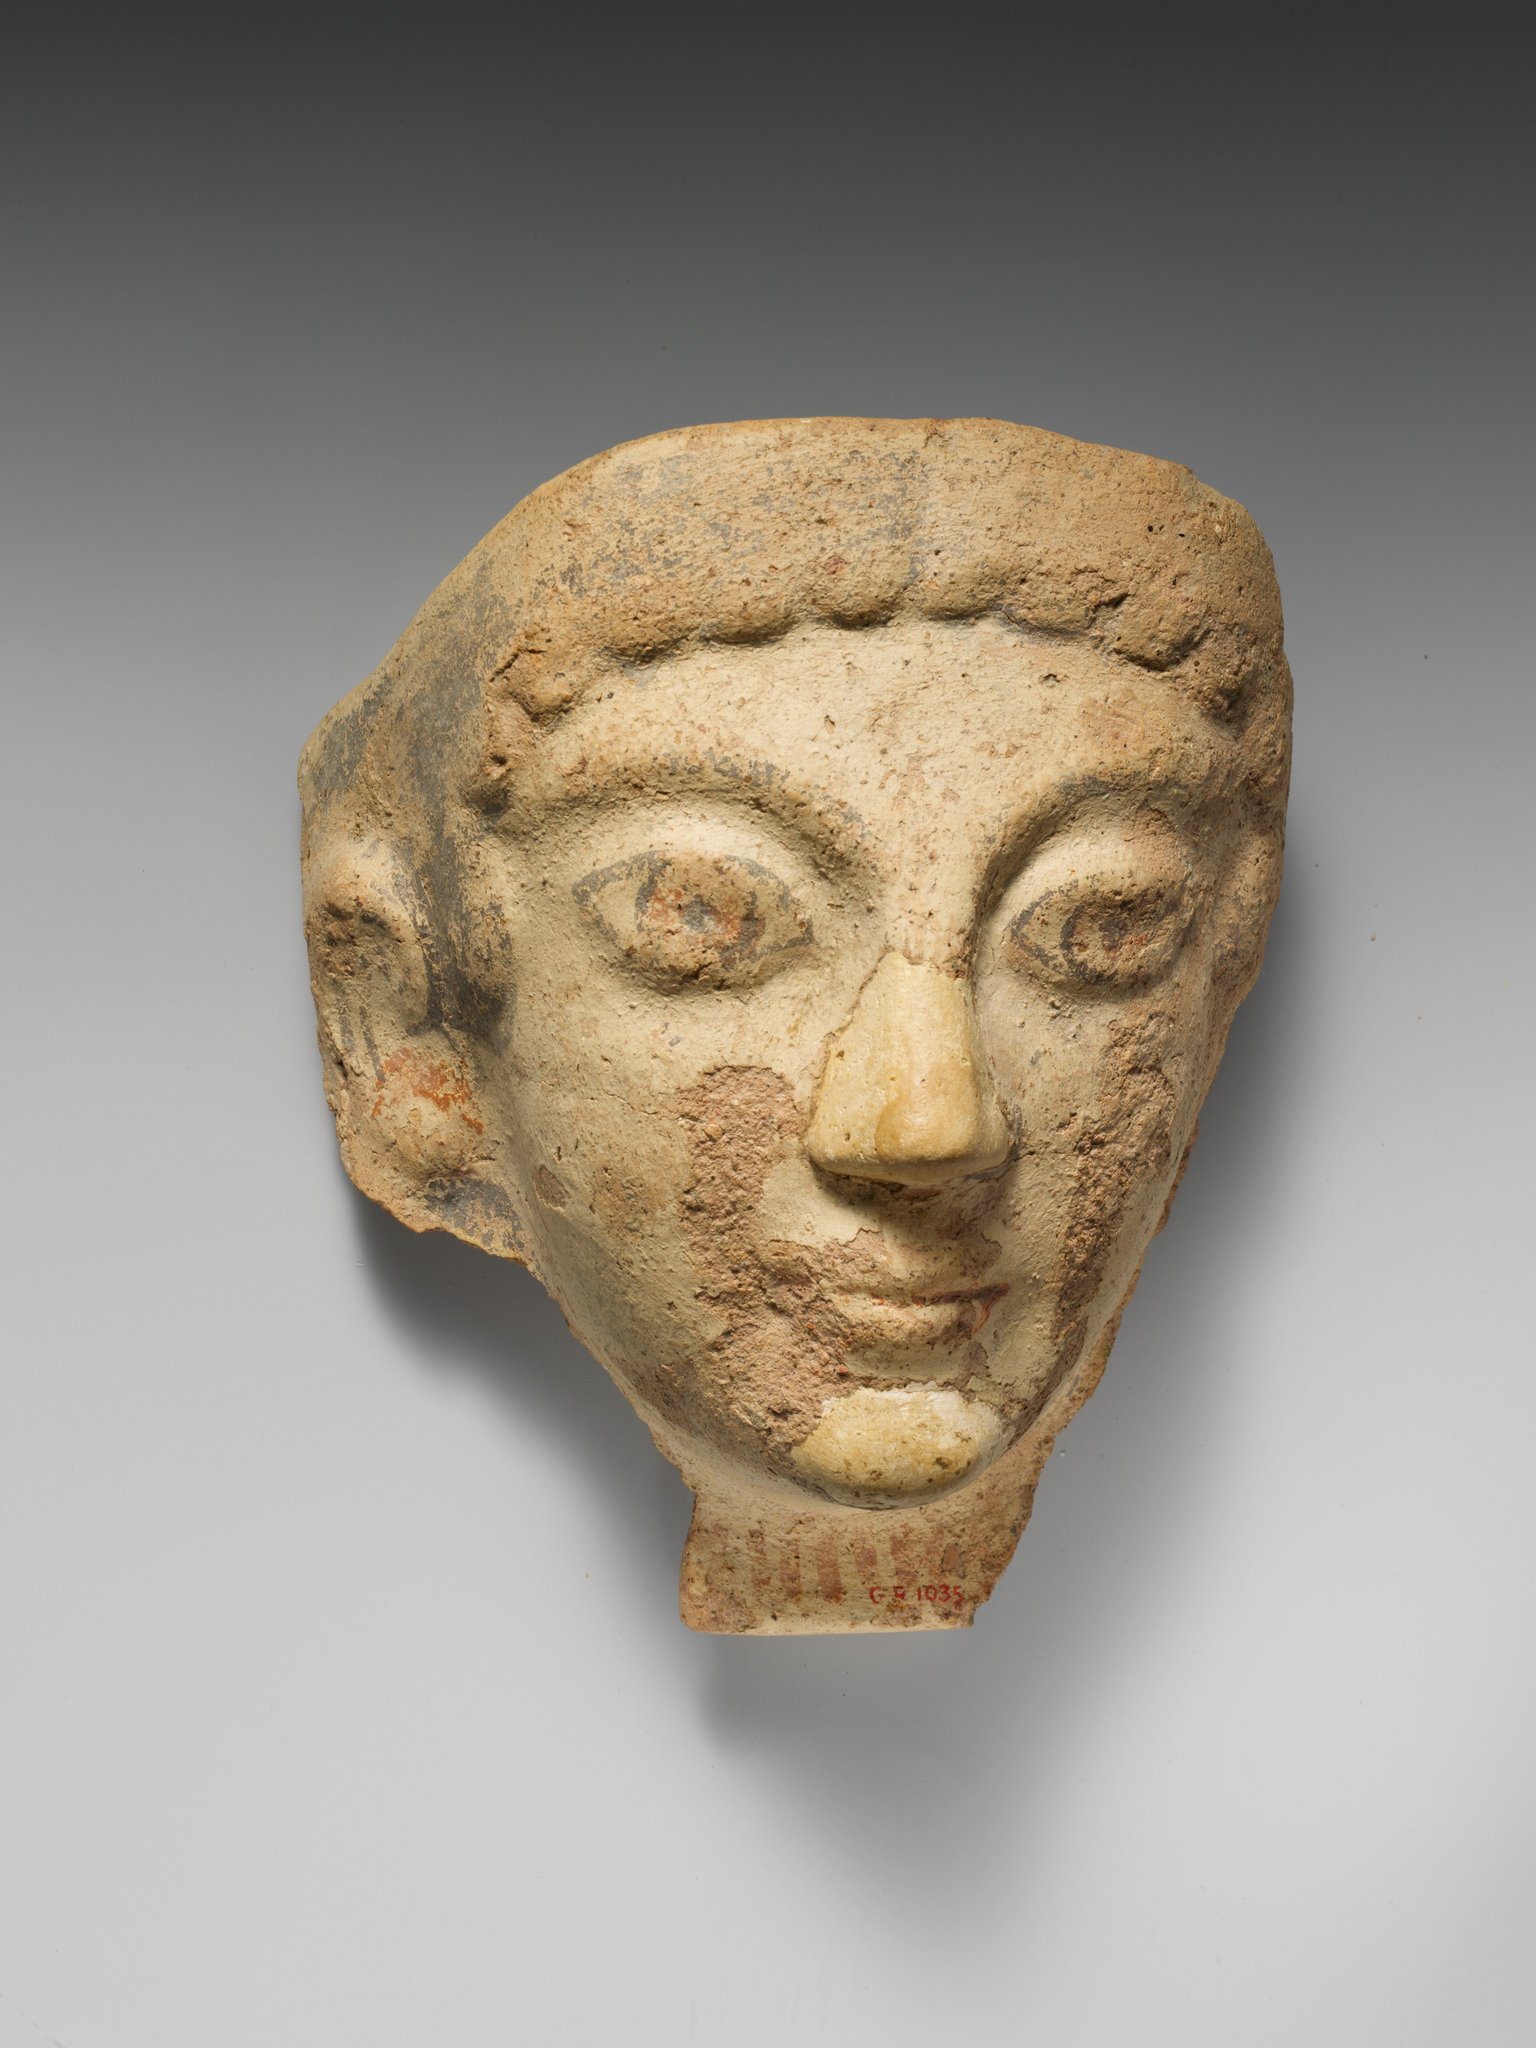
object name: antefix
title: Terracotta antefix (roof tile) with female head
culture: etruscan, cerveteri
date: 500-401 BCE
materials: terracotta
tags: heads,women